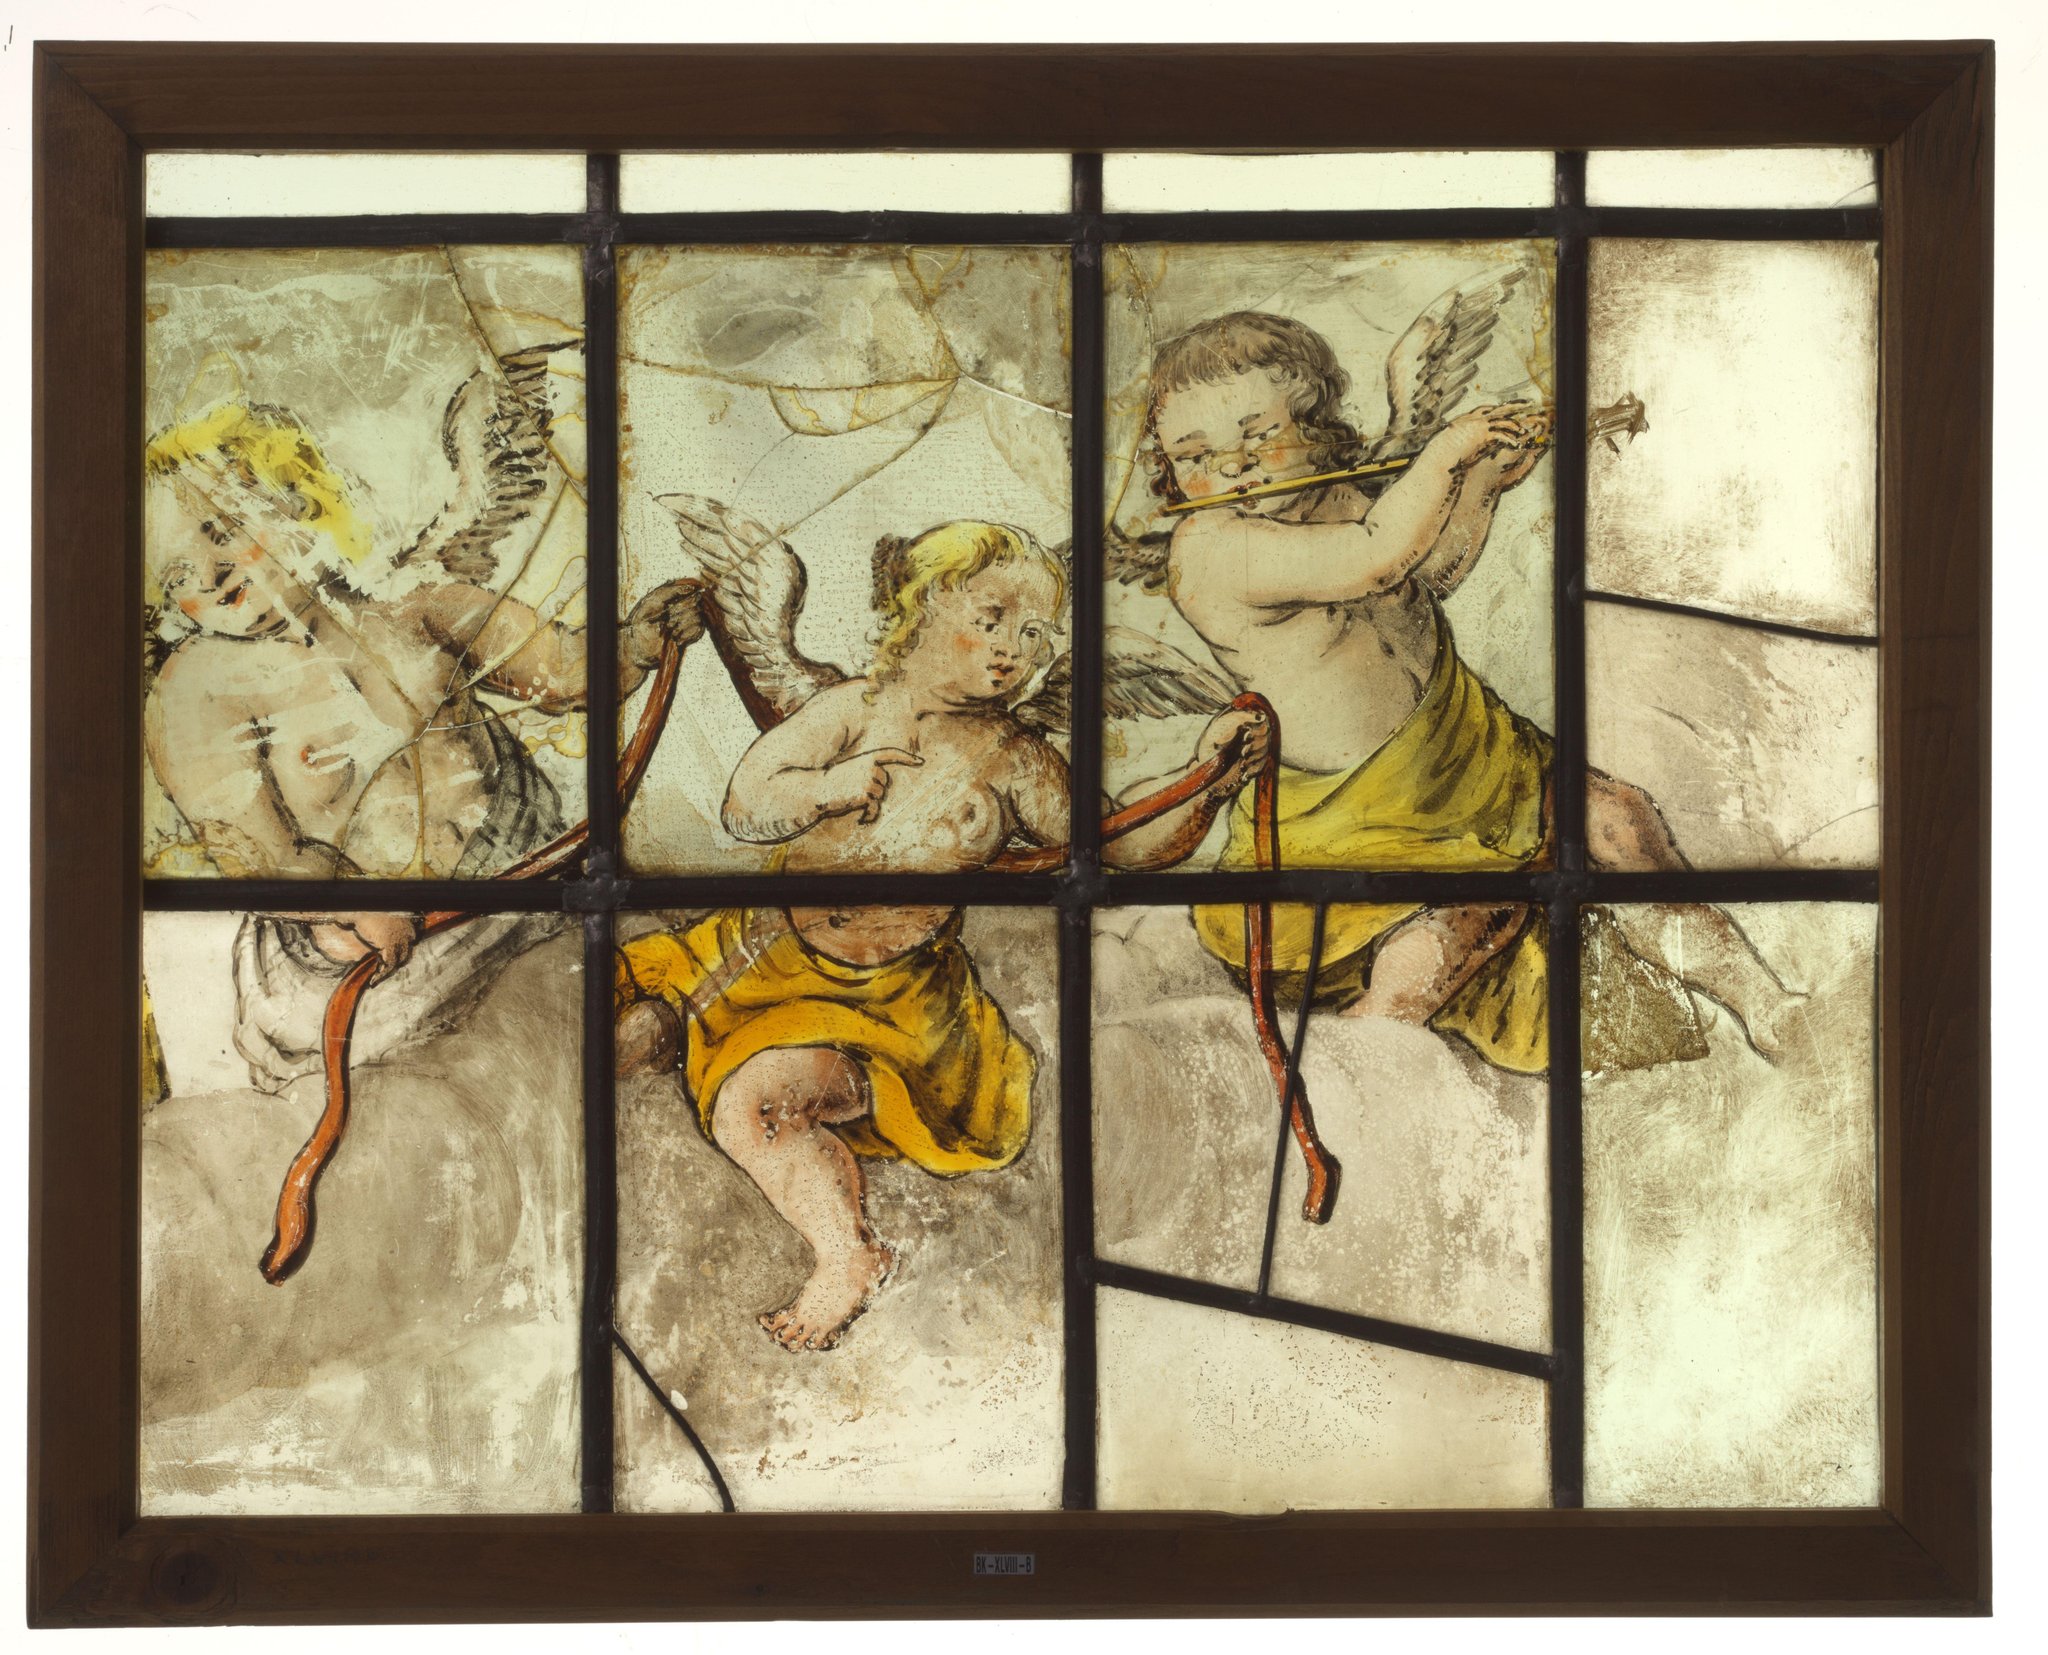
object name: light window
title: Ruit met drie engelen, waarvan één fluitspelend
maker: Anonymous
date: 1600-1699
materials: glass, lead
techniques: leading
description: Ruit met de voorstelling van drie engeltjes in de wolken waarvan één fluit speelt. Opmerking: Zie ook inv. nr. BK-XLVIII-A; zat eerder met deze ruit in één paneel.